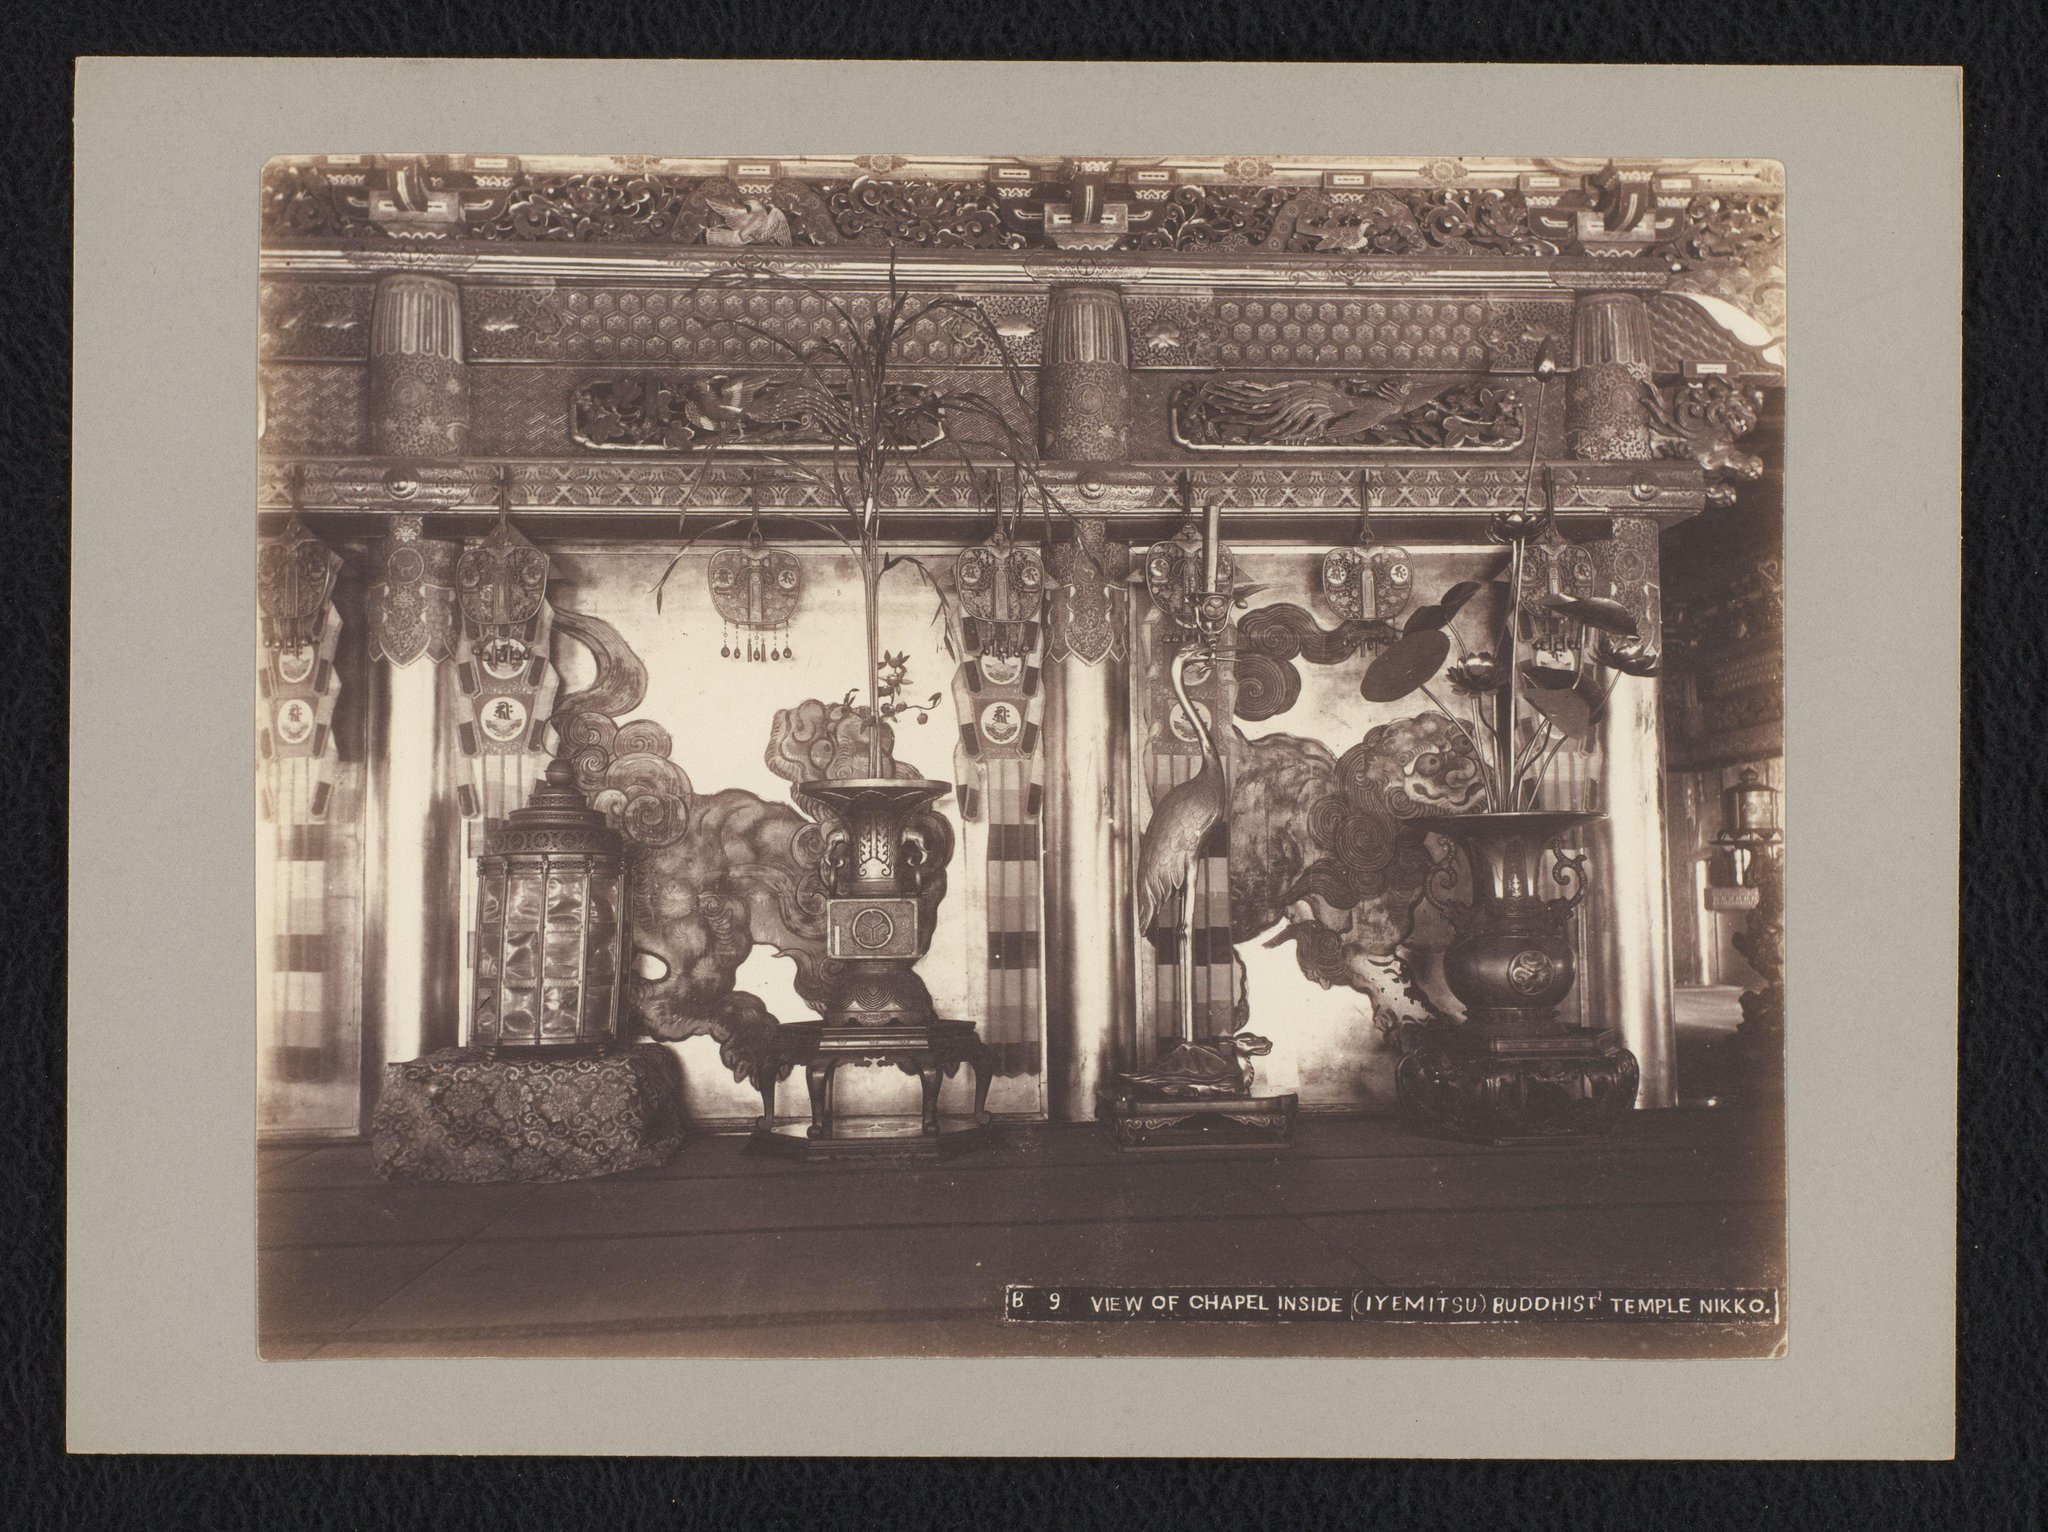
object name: photograph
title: Kapel in de Iyemitsu tempel, Nikko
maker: Anonymous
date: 1895-1915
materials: cardboard, photographic support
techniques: salted paper print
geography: nikko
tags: nikko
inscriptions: number: ‘36.’